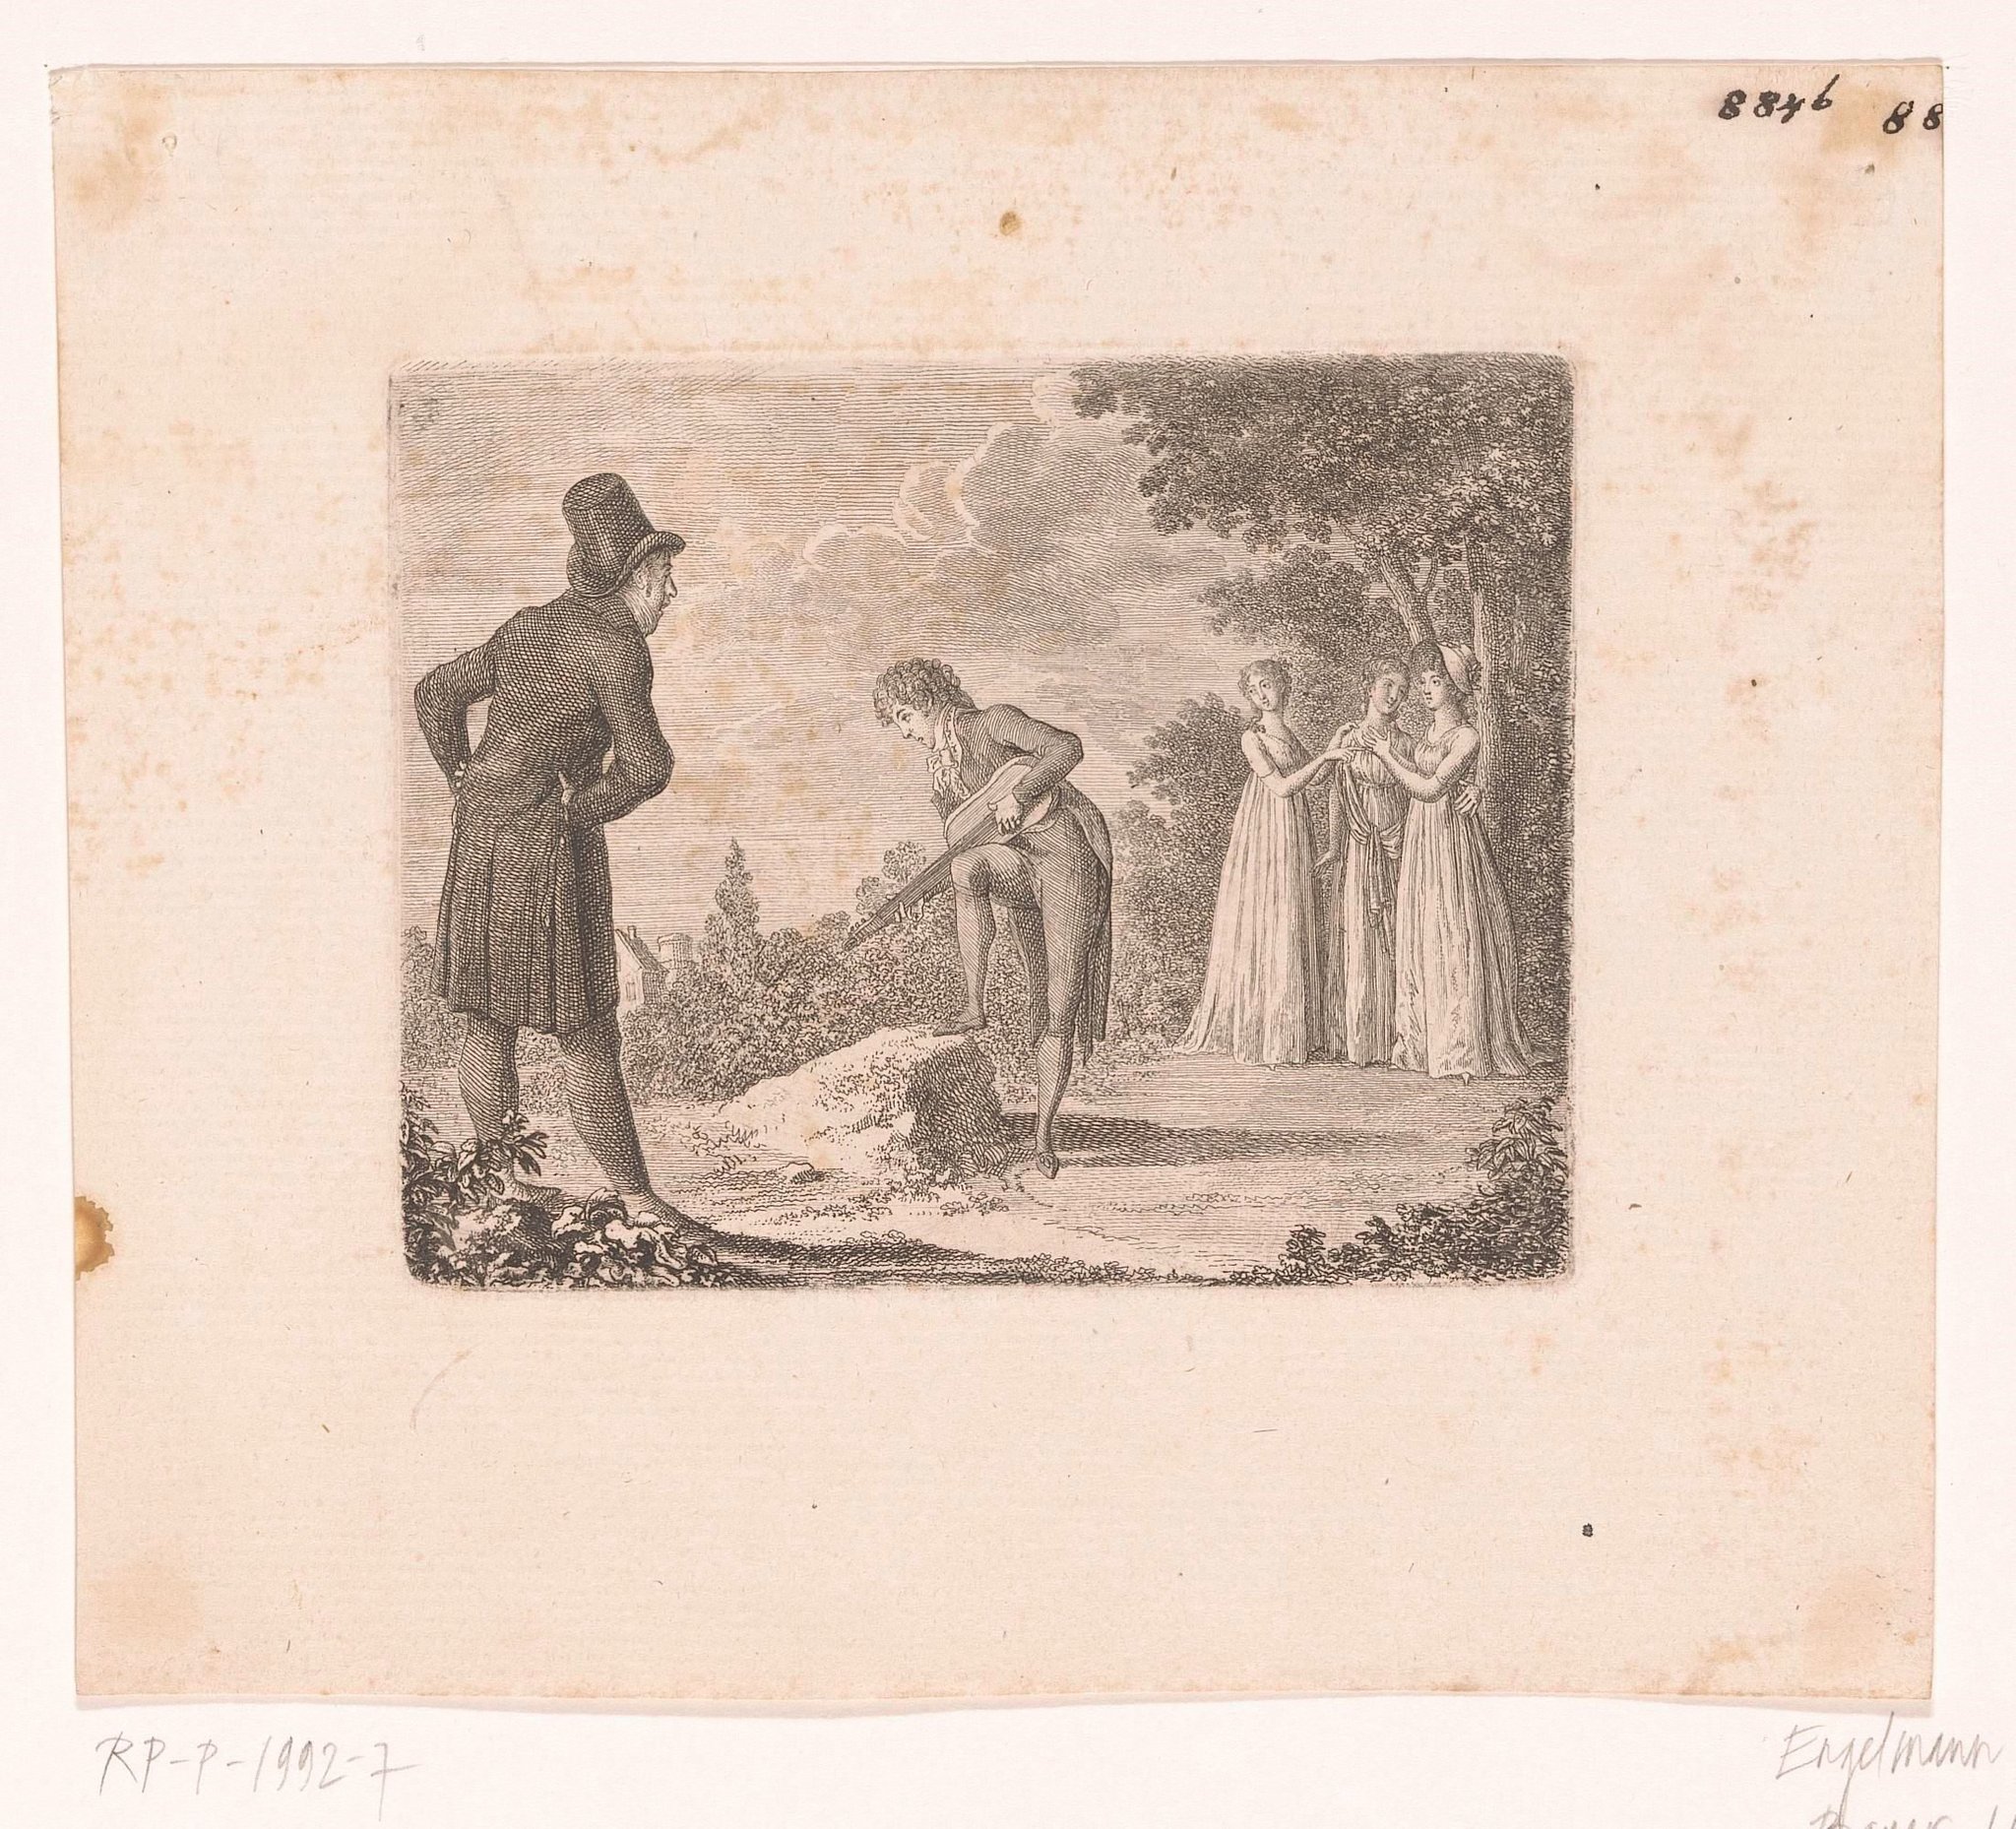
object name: print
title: Mr. de Vollange speelt op zijn gitaar, terwijl drie dames en een heer luisteren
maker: daniel nikolaus chodowiecki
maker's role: draughtsman, print maker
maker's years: 1726-1801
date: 1798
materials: paper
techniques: etching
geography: berlin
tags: adolescent, young woman, maiden, one person playing string instrument (plucked) - cc - out of doors, landscapes, actor (on the stage)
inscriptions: collector's mark: Lugt 2228